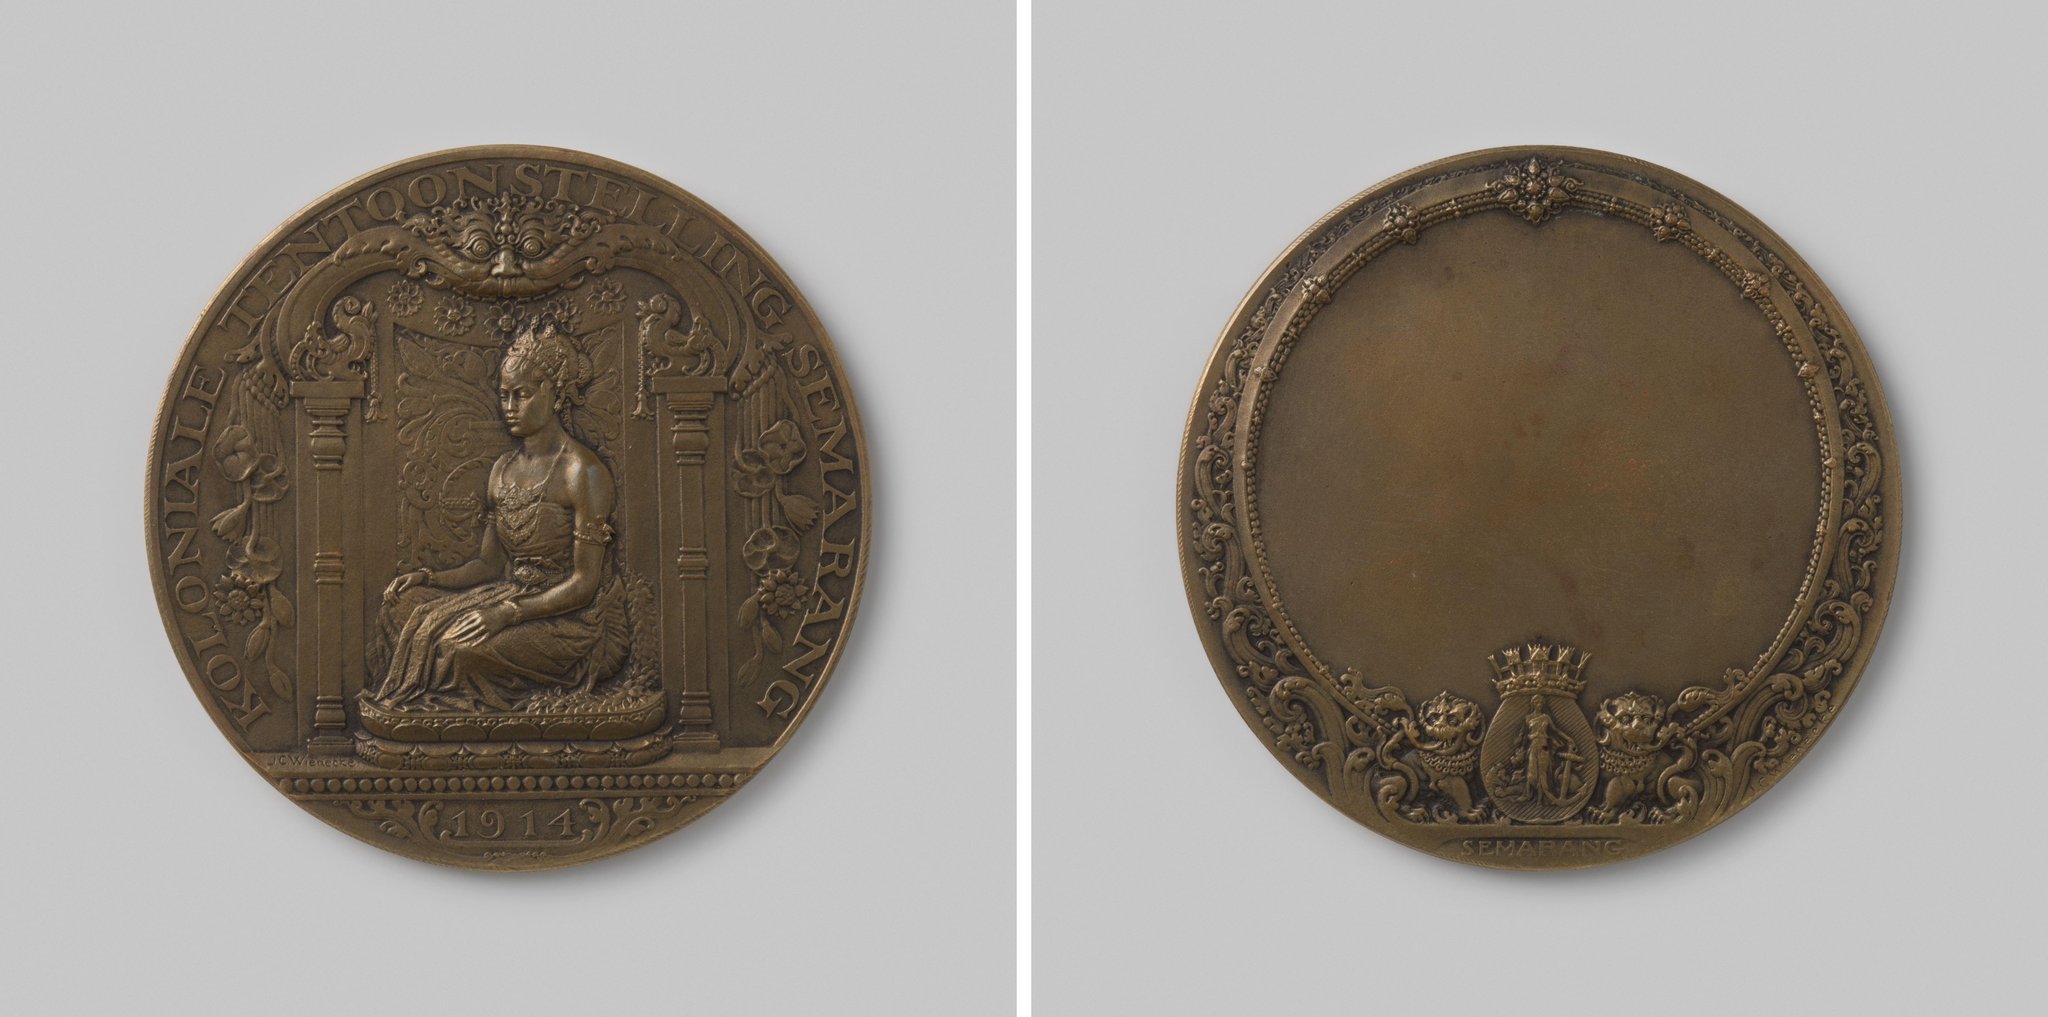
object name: history medal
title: Koloniale tentoonstelling te Semarang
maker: johannes cornelis wienecke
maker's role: medailleur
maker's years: 1872-1945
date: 1914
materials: bronze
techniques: casting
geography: netherlands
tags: semarang